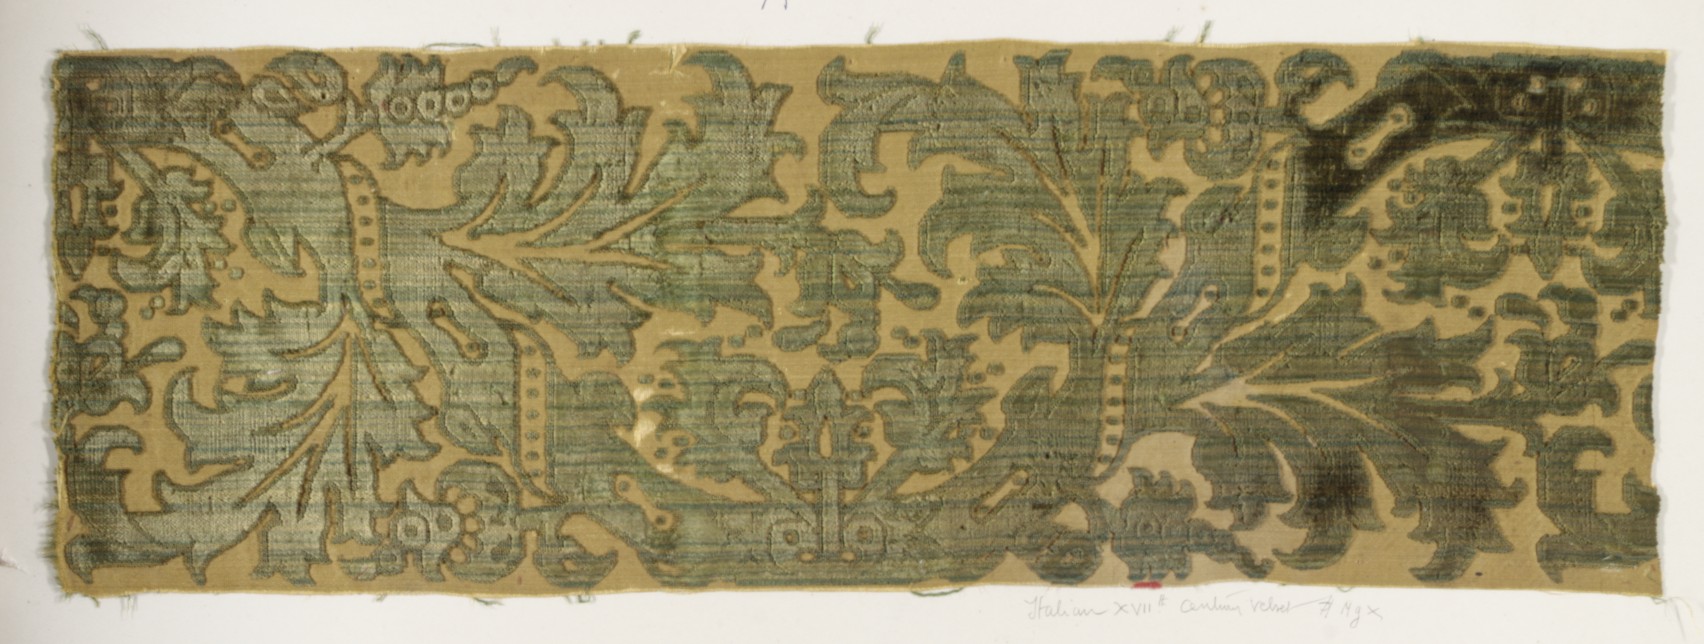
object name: fragment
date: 1601-1700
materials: silk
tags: leaves